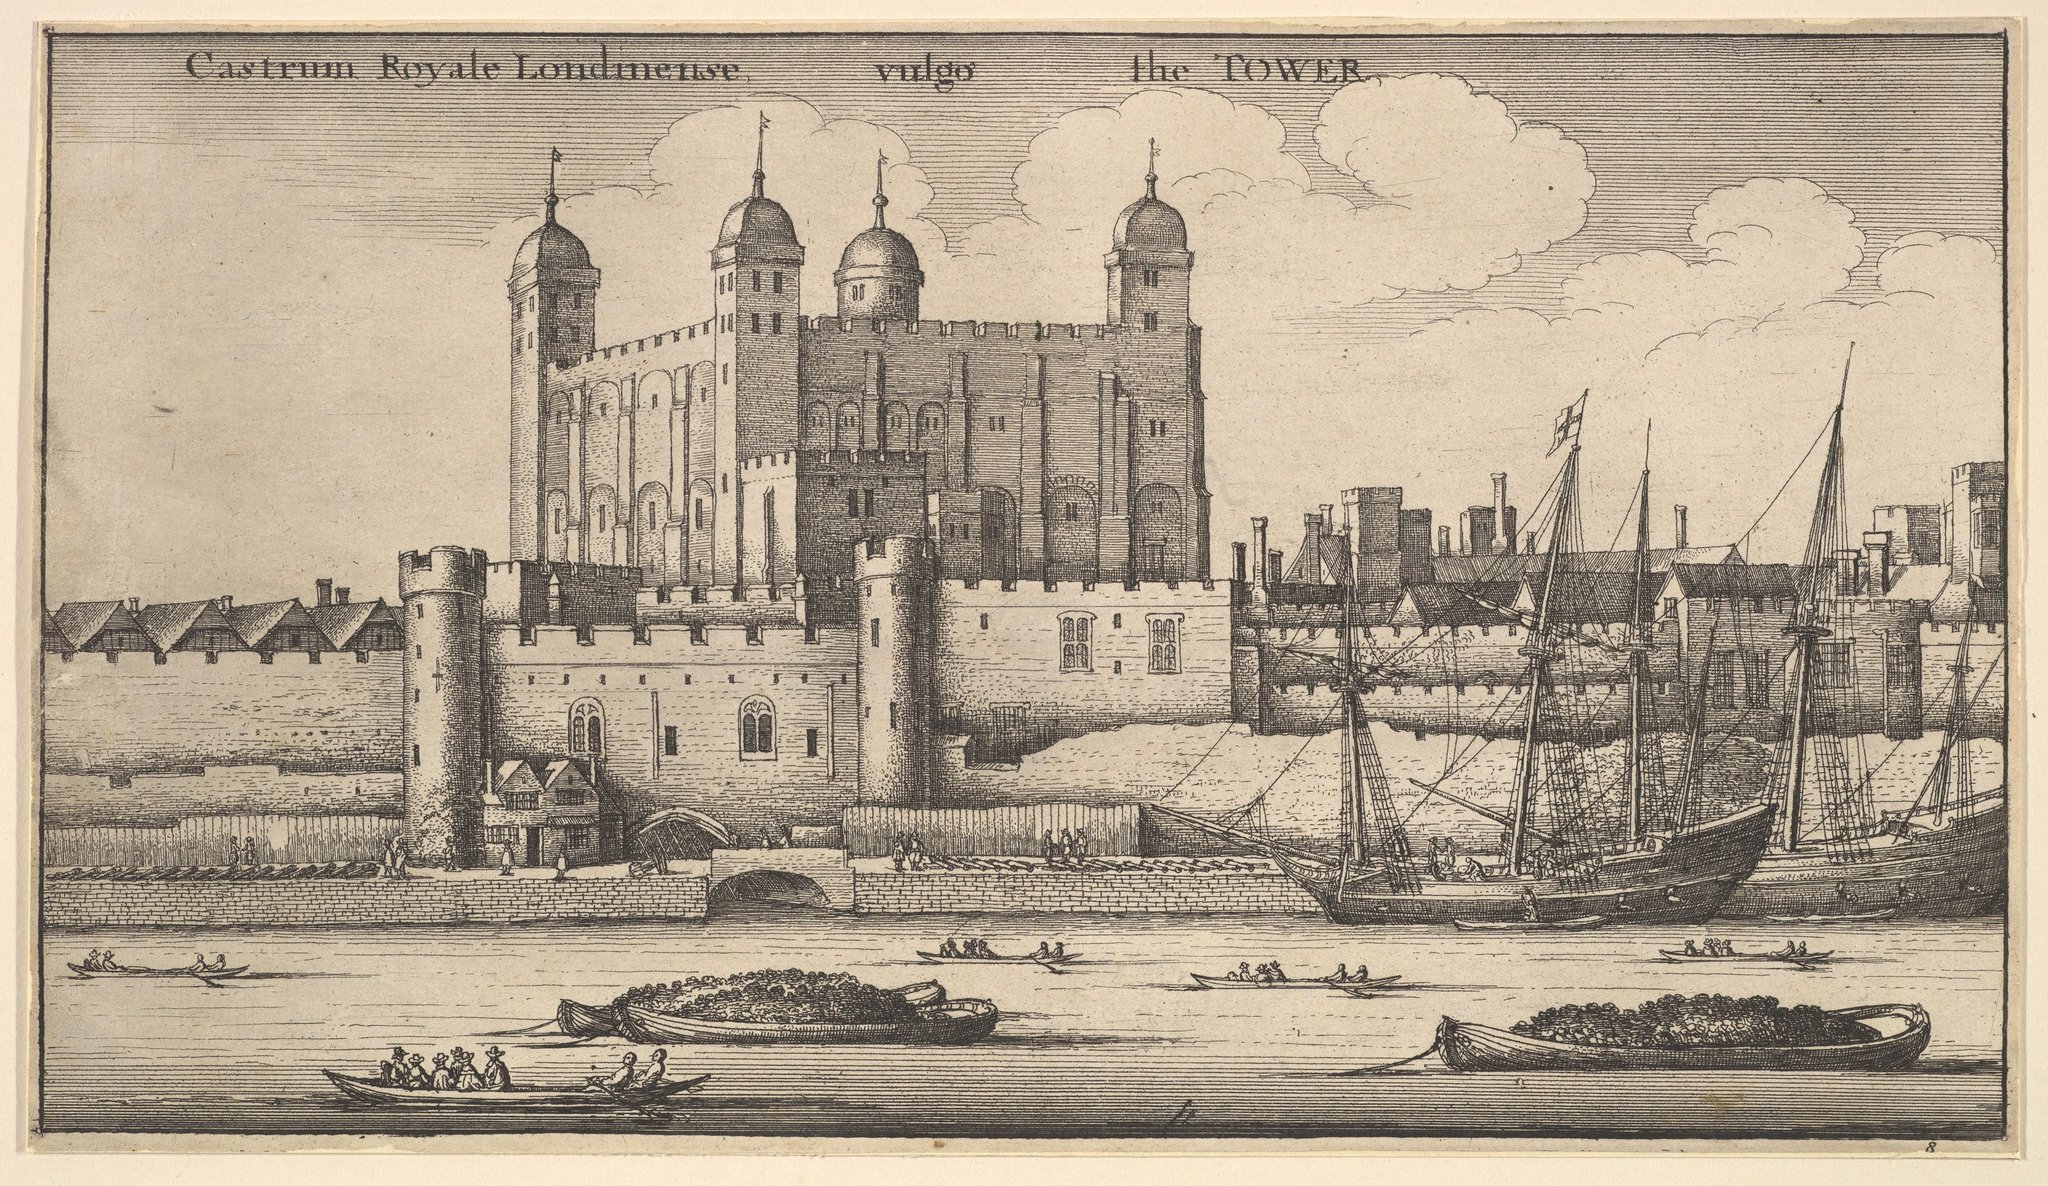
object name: print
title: Tower of London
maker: wenceslaus hollar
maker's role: artist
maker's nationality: bohemian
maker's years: 1607-1677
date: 1625-1677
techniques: etching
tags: gates,towers,rivers,boats,ships,london